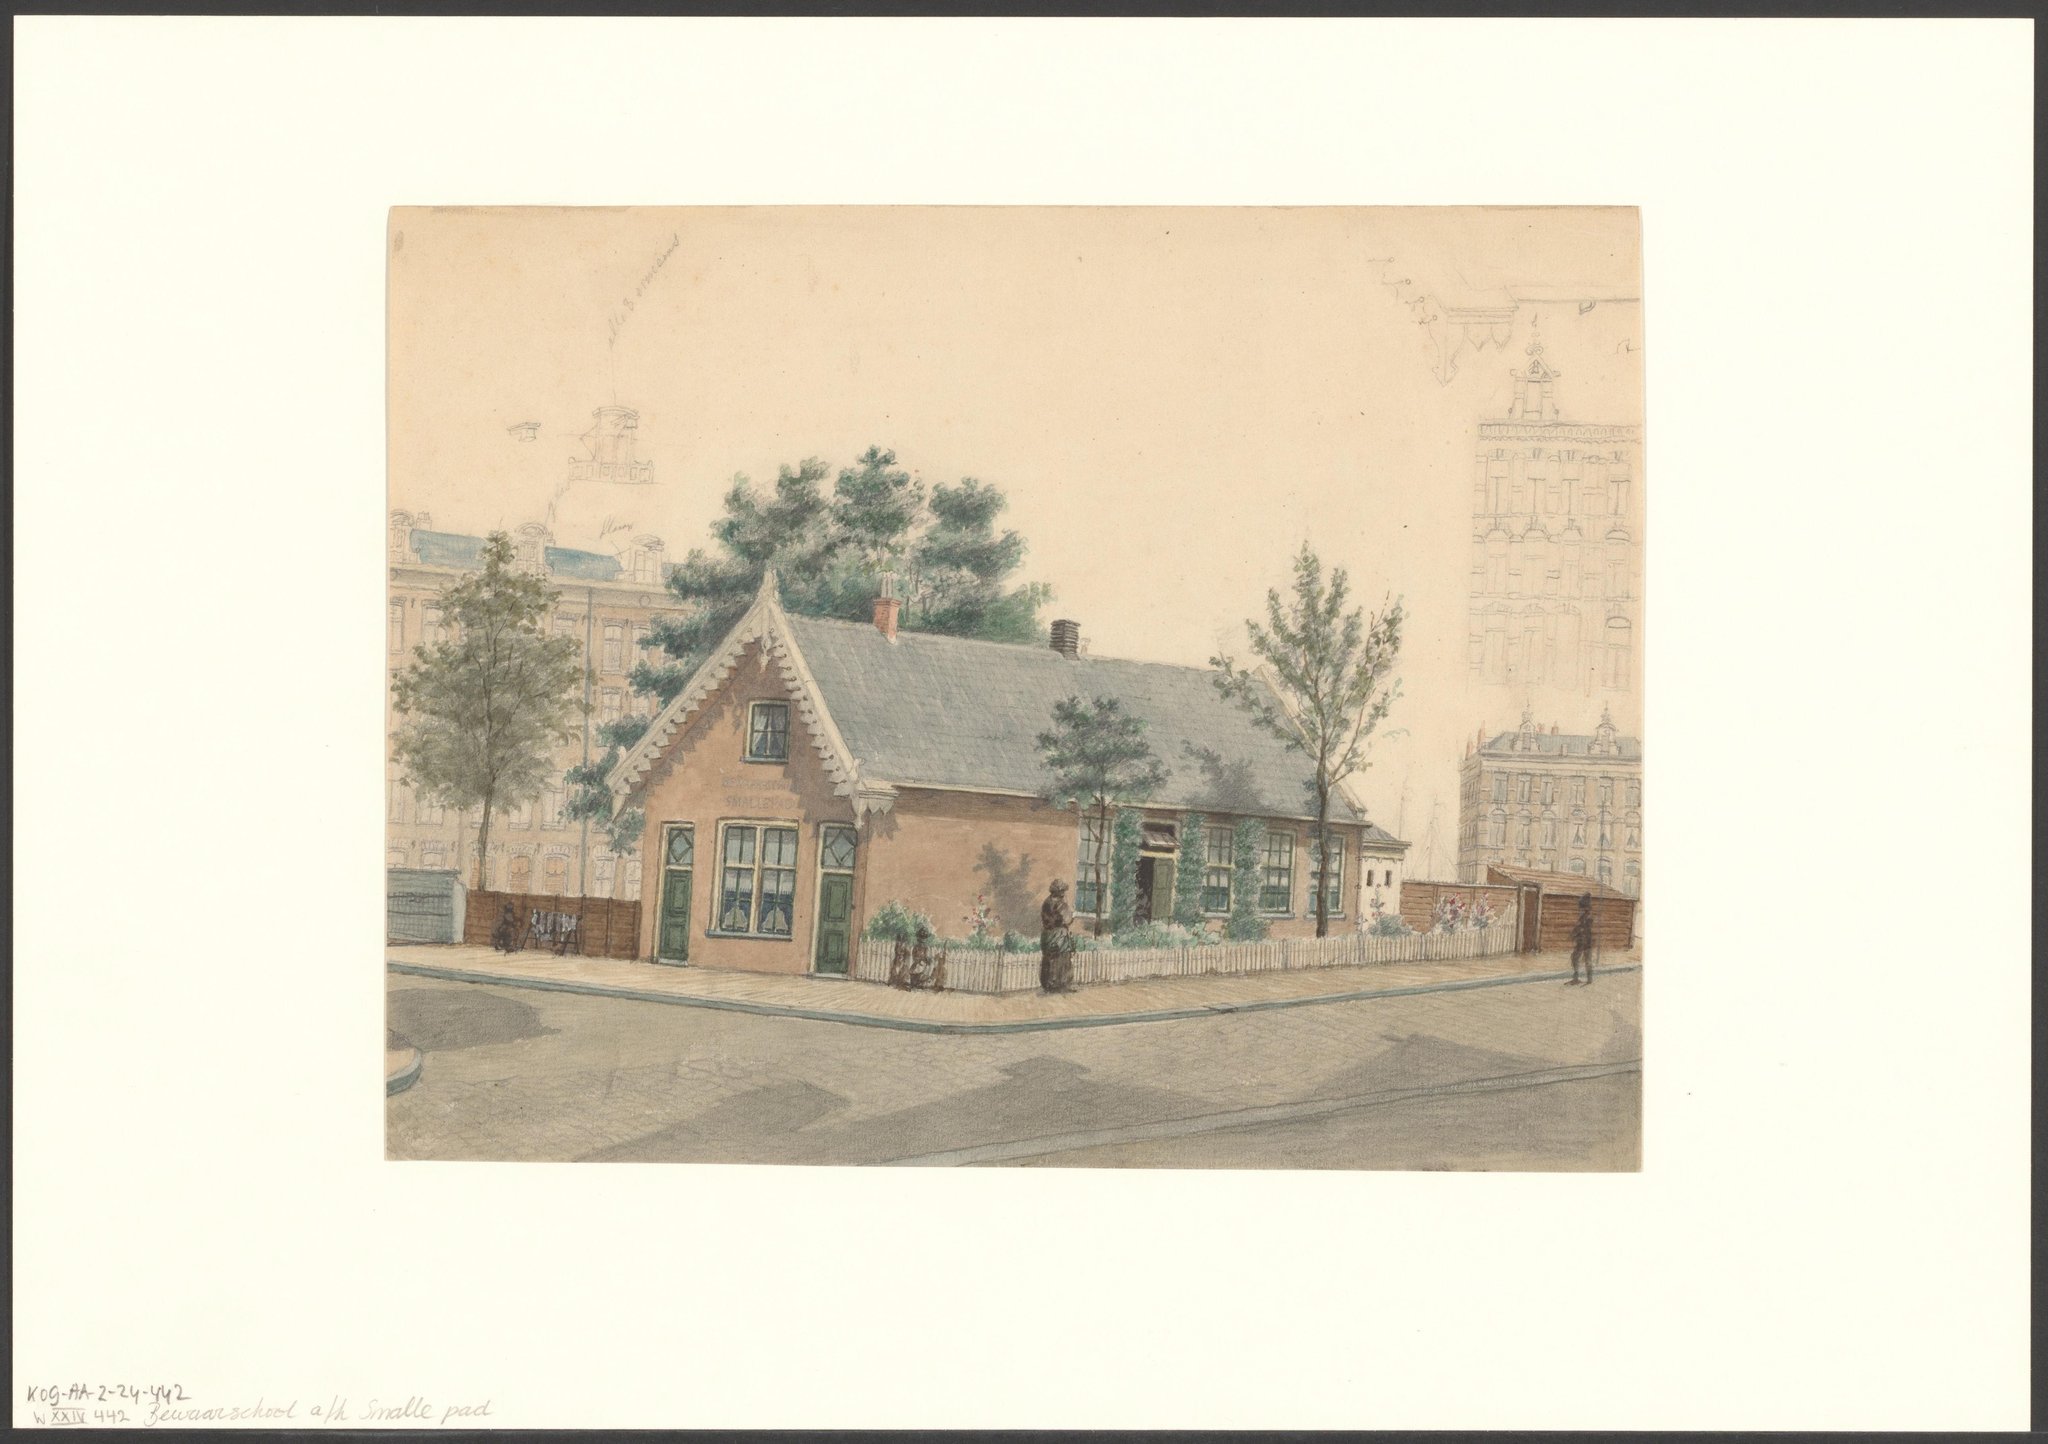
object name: drawing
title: Gezicht op bewaarschool Het Smallepad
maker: johan george lodewijk rieke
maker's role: draughtsman, print maker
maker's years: 1817-1898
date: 1884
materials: paper, pencil, watercolor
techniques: brush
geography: amsterdam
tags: city-view in general; 'veduta', street, nursery school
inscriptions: collector's mark: Lugt 800a, date: ‘geteekend 15 Augustus 1884’, inscription: ‘Bewaarschool voor kinderen / Smallepad’, number: ‘5/130’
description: Tekening binnen de Atlas Van Eck ingedeeld op wijknummer 24.